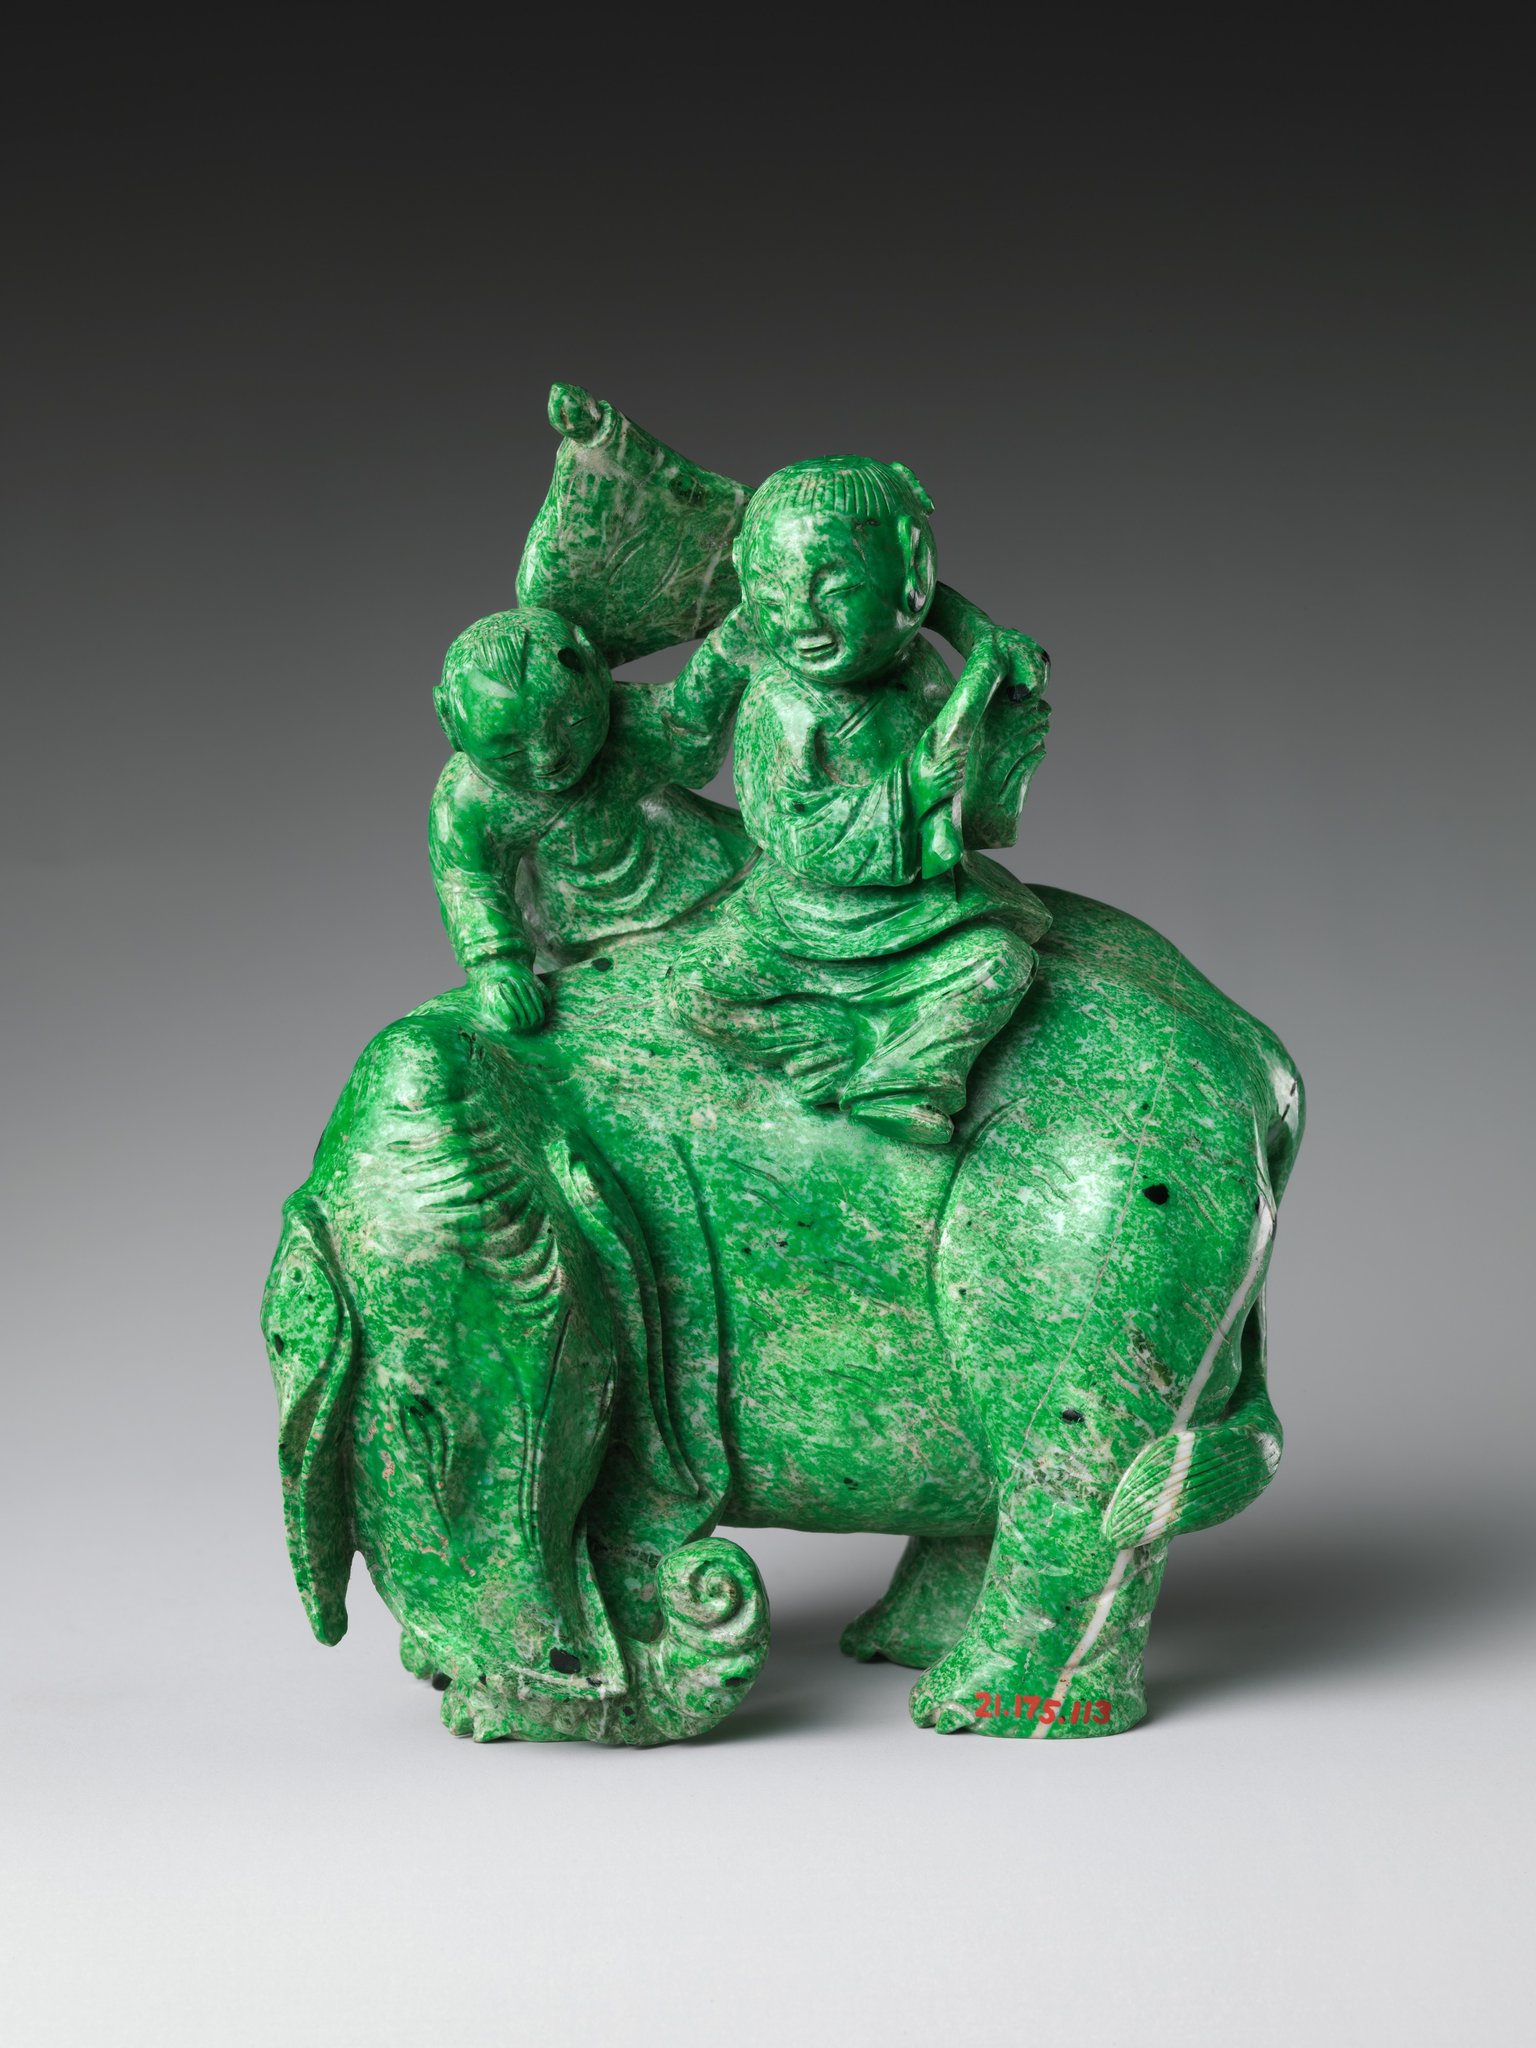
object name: figure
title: Elephant and two boys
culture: chinese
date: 1801-1900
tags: boys,elephants